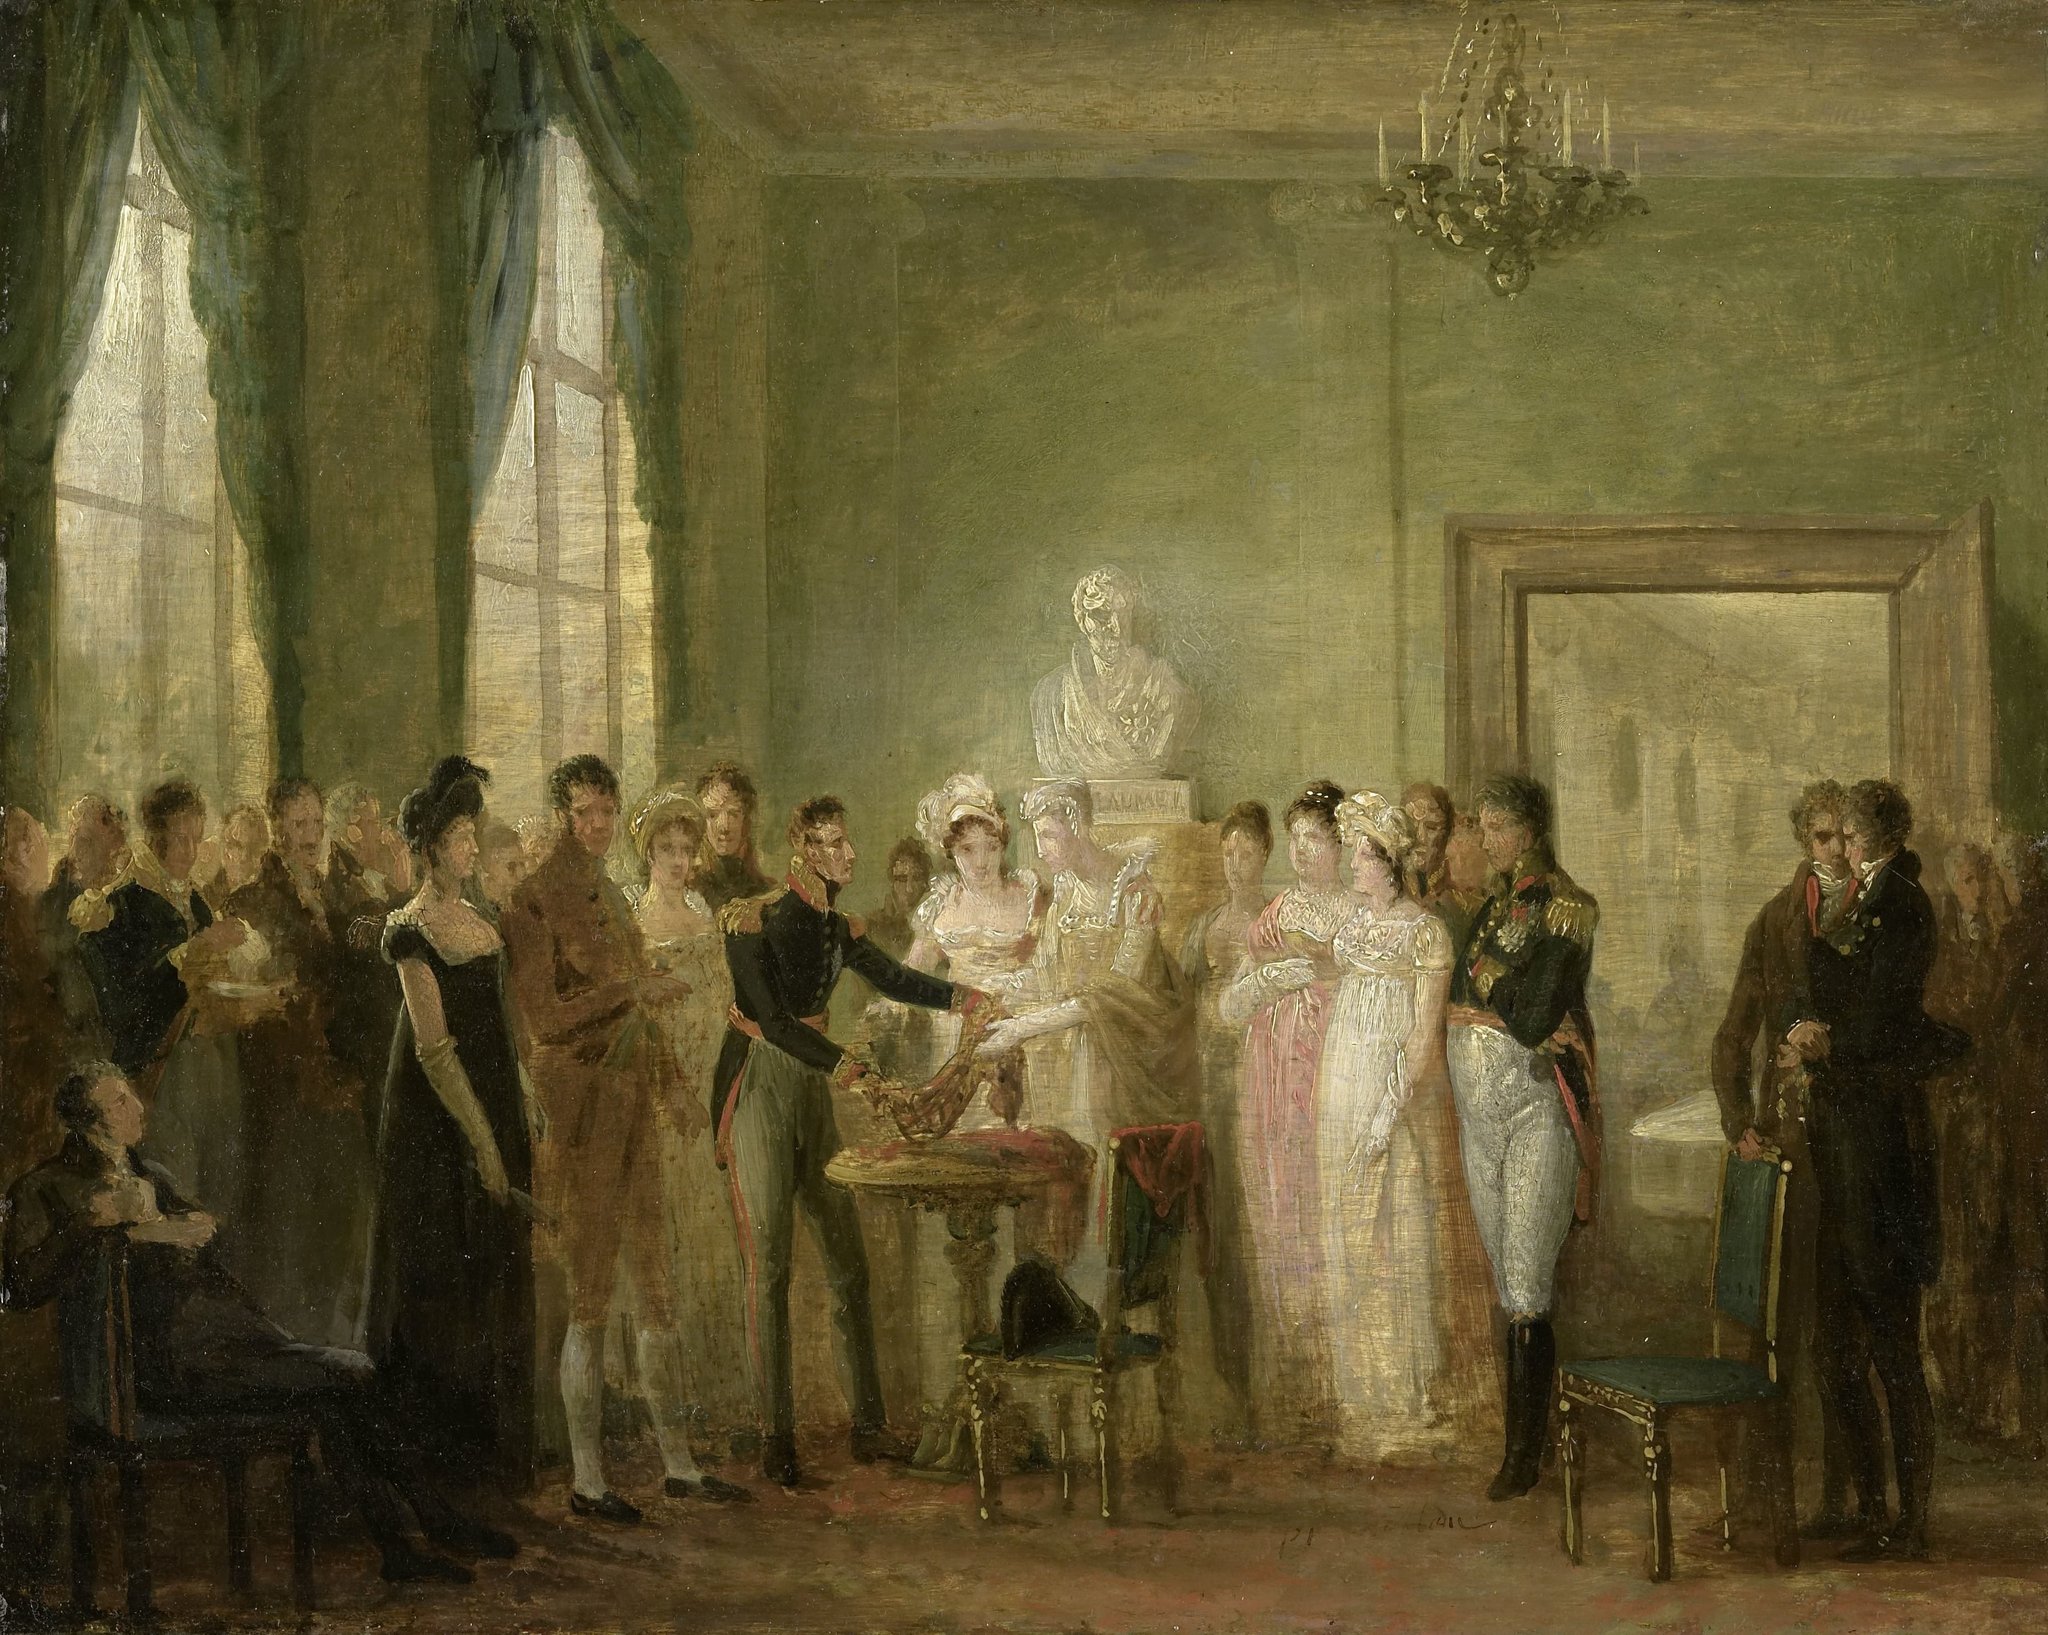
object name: painting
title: An Unidentified Historical Subject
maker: mattheus ignatius van bree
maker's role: draughtsman, print maker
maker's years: 1773-1839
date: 1815-1830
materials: oil, panel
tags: the hague, berlin, william i of the netherlands, william ii of the netherlands, interior of the house, private festivities, merry company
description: Ongeïdentificeerde historische voorstelling. In een interieur heeft een groep voorname mannen en vrouwen zich verzameld rond een kleine tafel. Hier overhandigt een man een kledingstuk aan een vrouw. Tegen de muur een buste van koning Willem I.